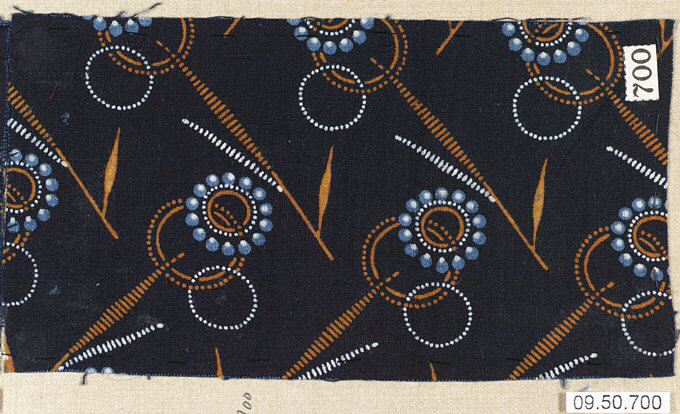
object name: piece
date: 1801-1900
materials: cotton